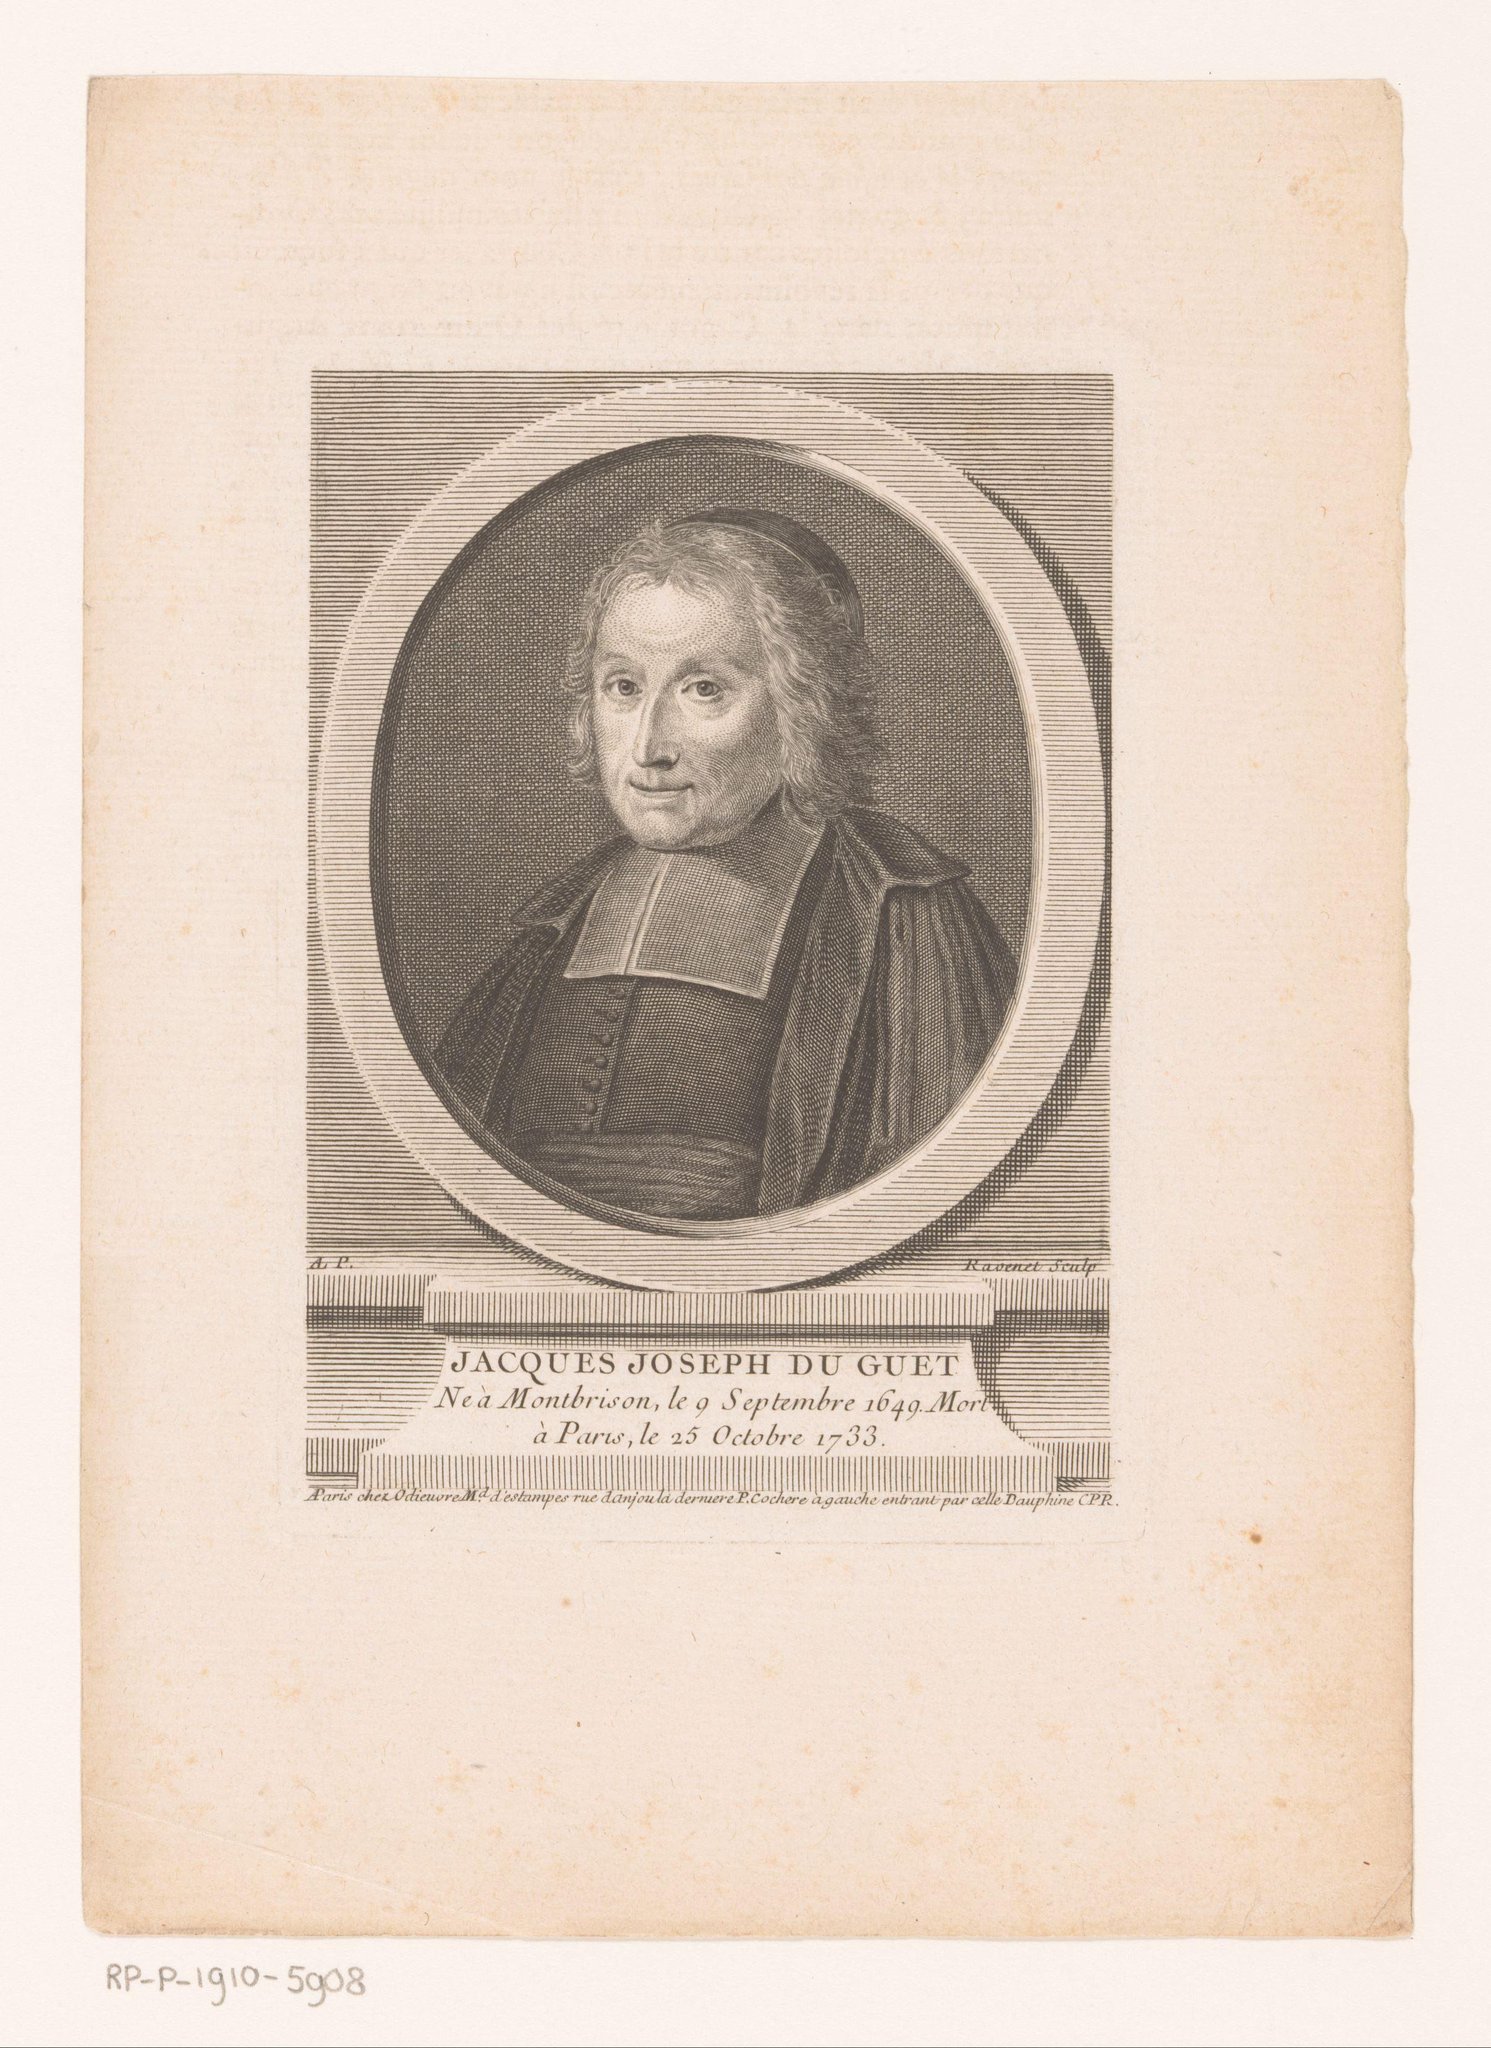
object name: print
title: Portret van Jacques Joseph Duguet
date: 1733-1756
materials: paper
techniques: engraving, etching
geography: france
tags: paris, theologian, historical persons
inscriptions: collector's mark: Lugt 2228